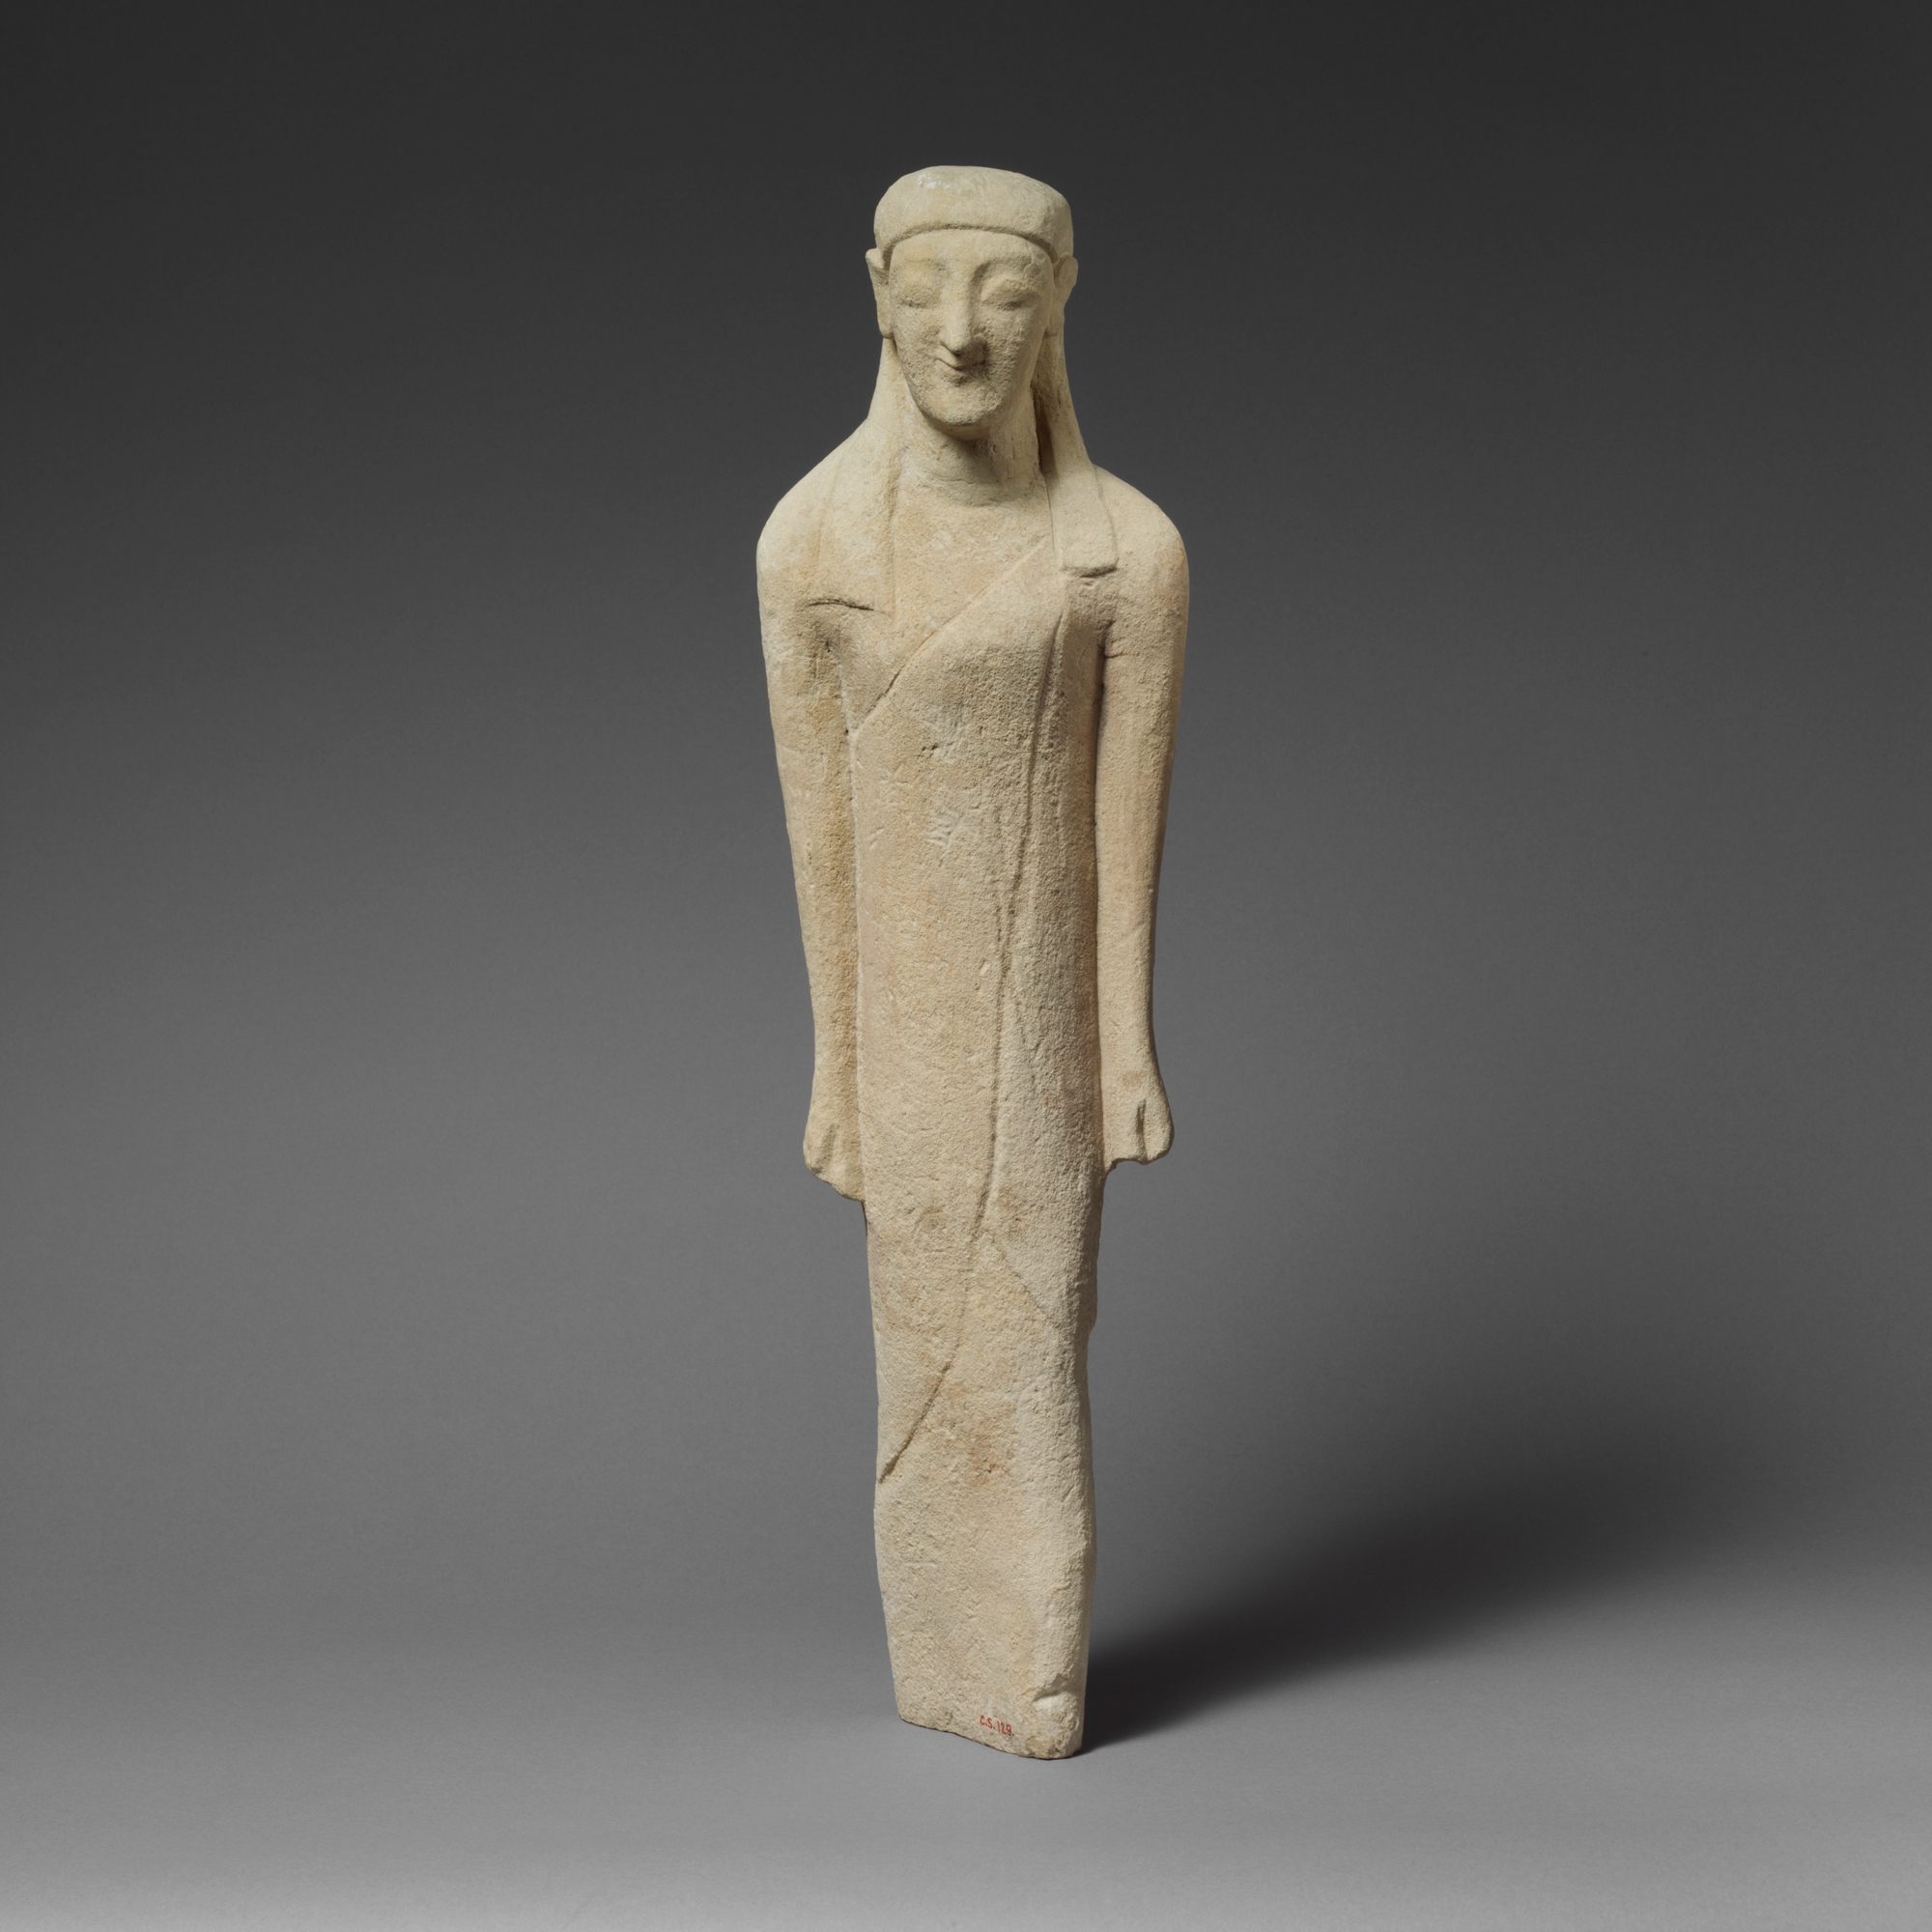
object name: statue of a votary, male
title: Limestone statuette of a beardless male votary in Greek dress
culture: cypriot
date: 567-535 BCE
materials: limestone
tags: men